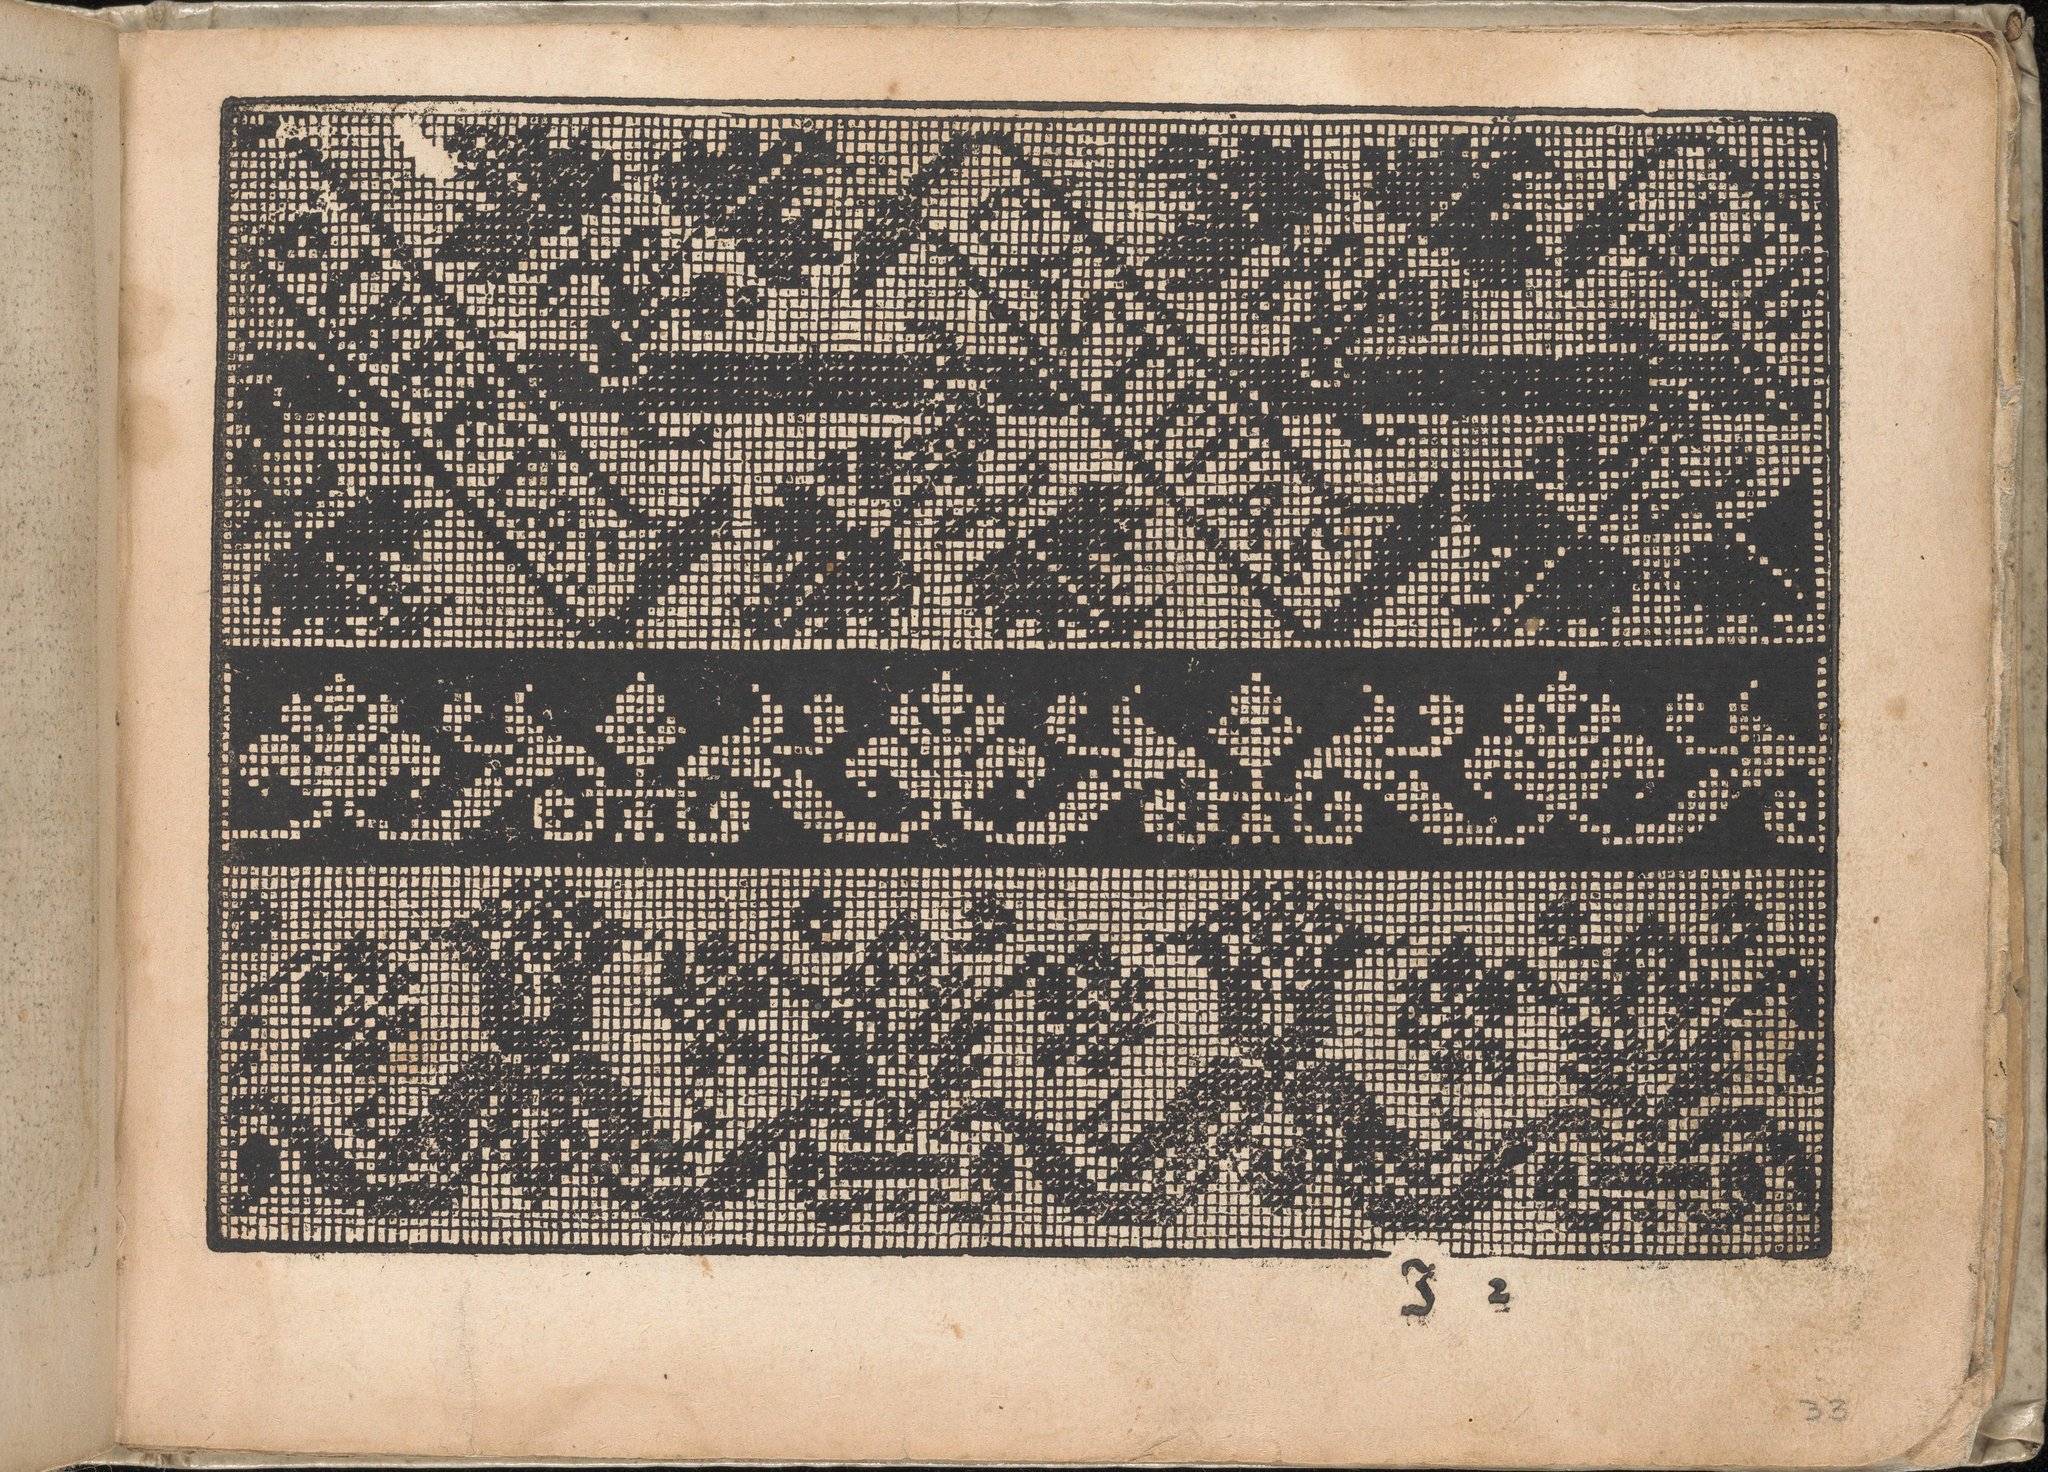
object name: book print ornament architecture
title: Neu künstlich Modelbuch (page 33r)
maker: bernhard jobin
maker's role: publisher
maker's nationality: swiss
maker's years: 1535-1597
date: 1598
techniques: woodcut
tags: ornament